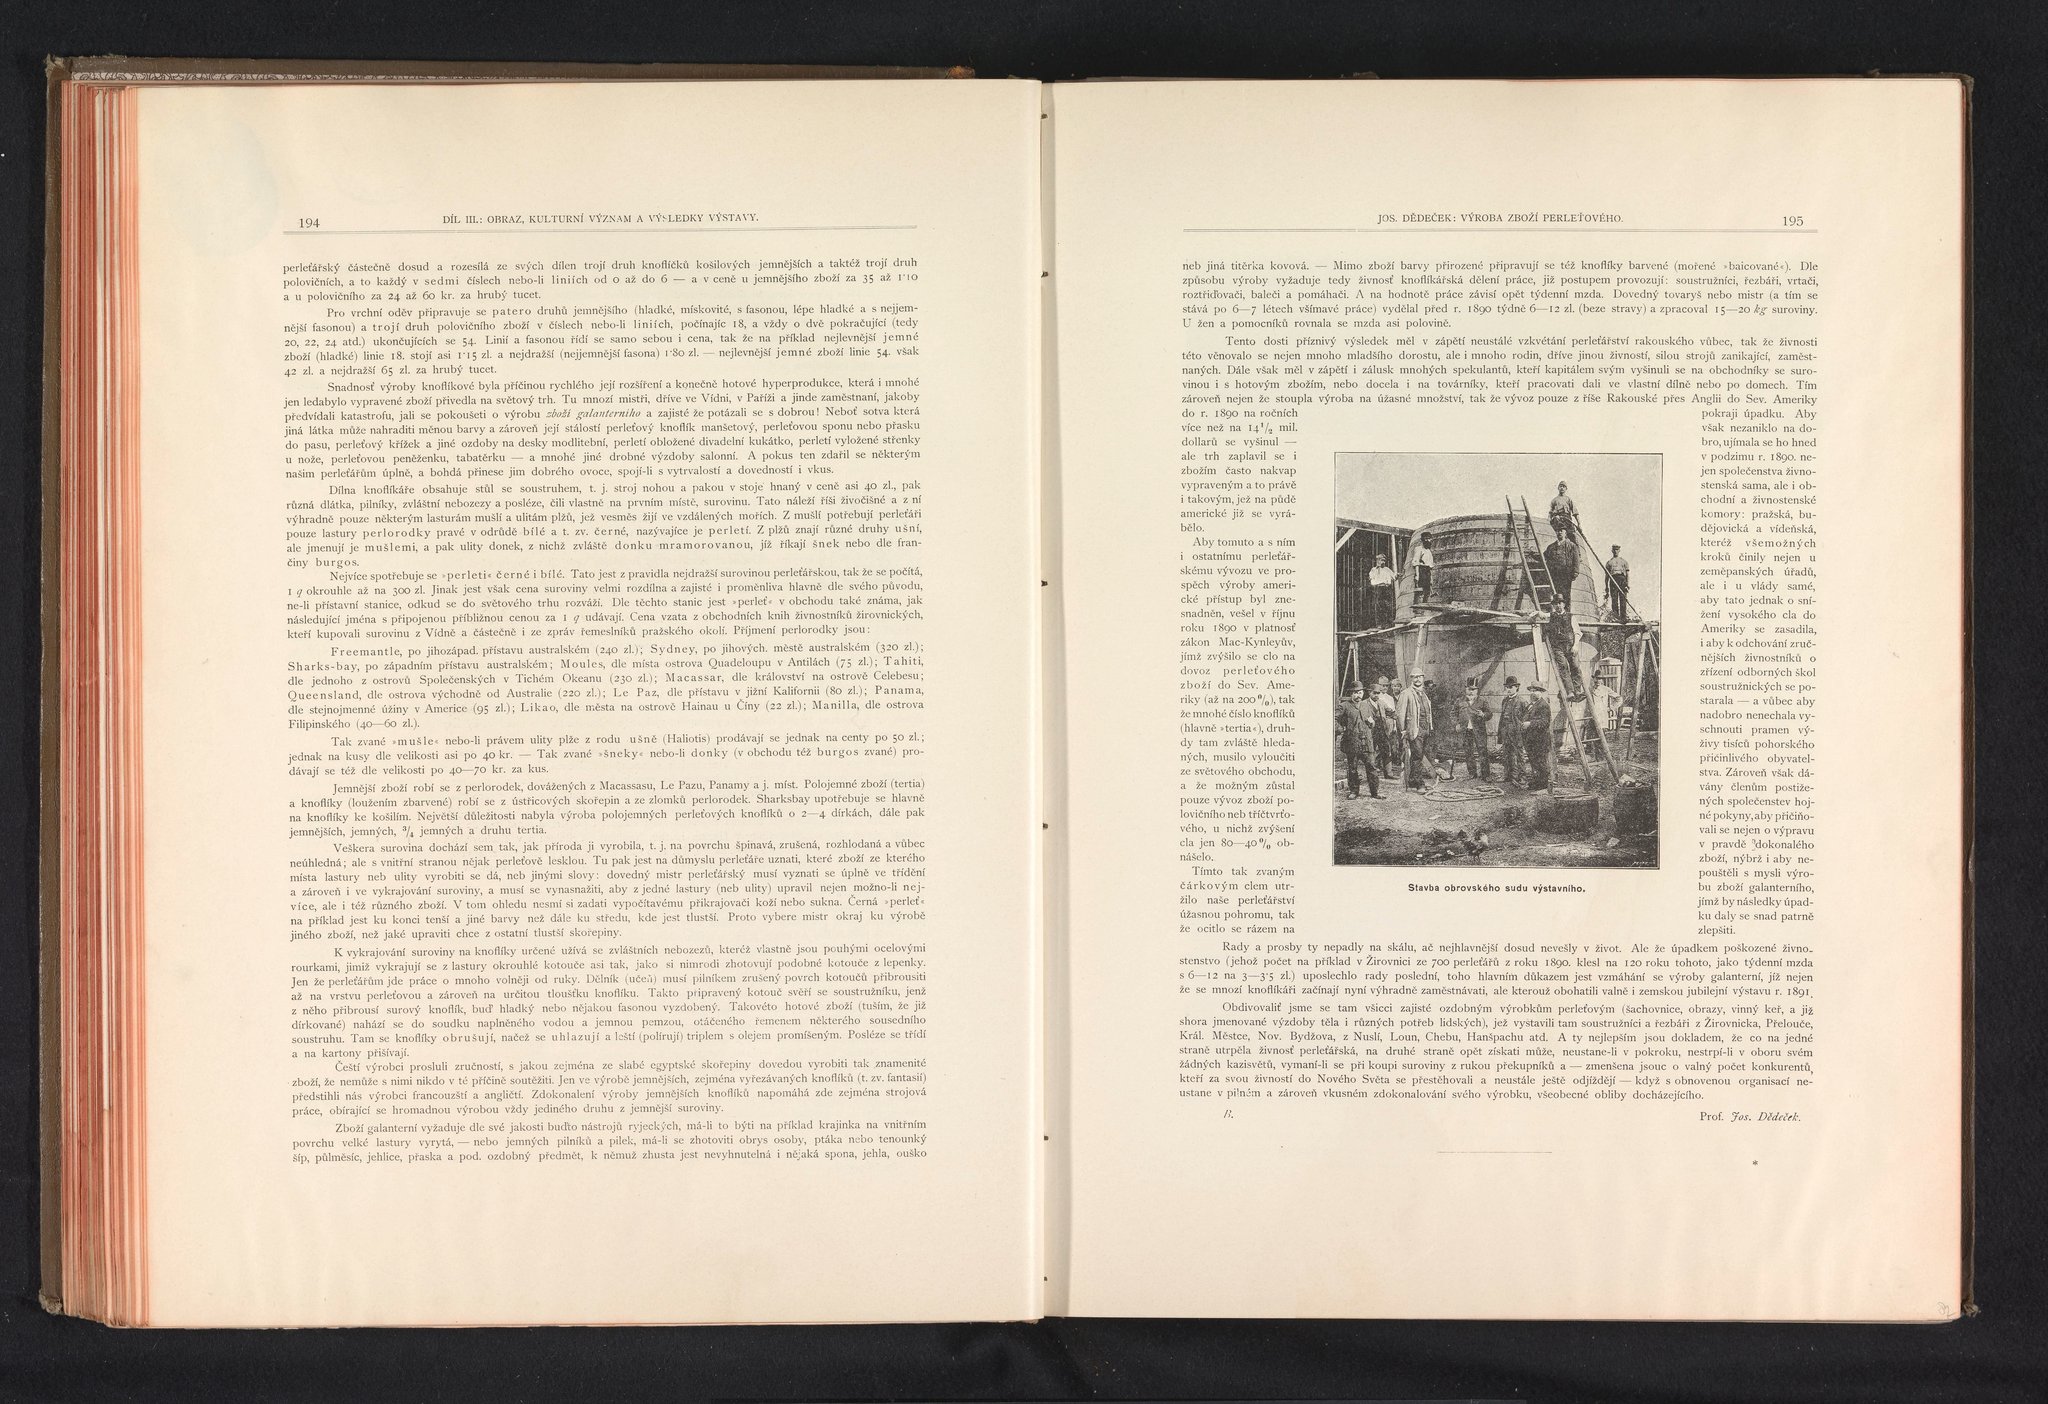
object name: page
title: Groepsportret van onbekende mannen rond een houten ton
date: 1890-1895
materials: paper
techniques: autotype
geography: prague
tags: wooden container: barrel, cask, bucket, anonymous historical persons portrayed in a group, in a group-portrait